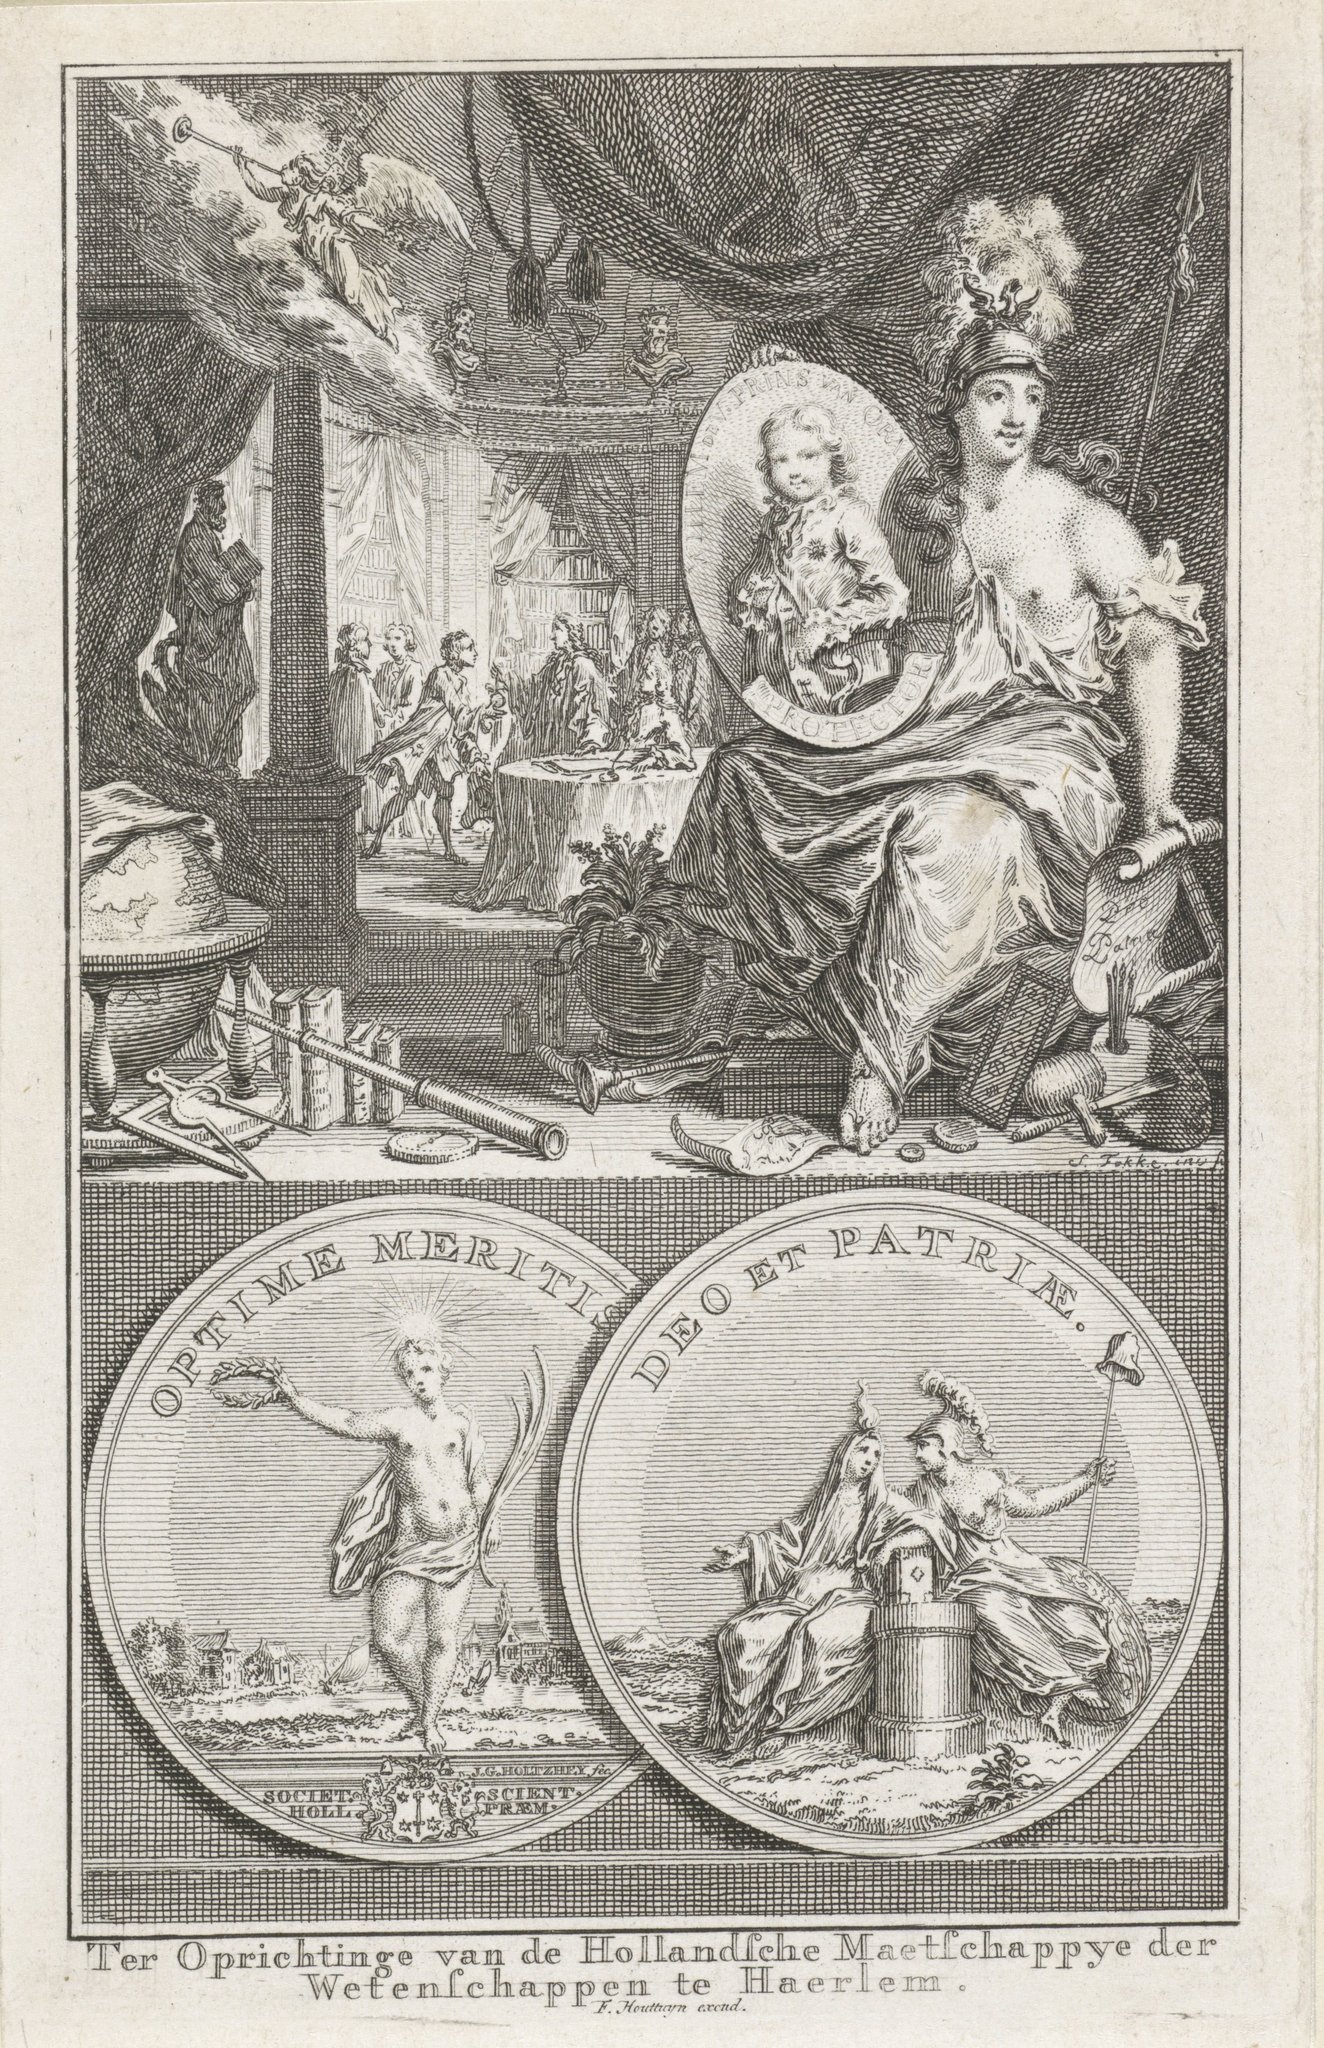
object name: print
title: Ter Oprichtinge van de Hollandsche Maatschappye der Wetenschappen te Haerlem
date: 1752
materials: paper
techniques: engraving, etching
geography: amsterdam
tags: william v (prince of orange), learned society, academy of sciences, (story of) minerva (pallas, athena), haarlem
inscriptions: collector's mark: Lugt 2228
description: Allegorie op de oprichting van de Hollandsche Maatschappij der Wetenschappen te Haarlem op 21 mei 1752. Boven Minerva met een portret van de beschermheer Willem V, op de achtergrond een bijeenkomst van wetenschappers. Onder de zijden van een gedenkpenning met naakte Waarheid met zon op hoofd, houdt in linkerhand een palmtak en in rechterhand een olijfkrans; op achtergrond gezicht op stad Haarlem aan het Spaarne, onderaan het stadswapen van Haarlem. Keerzijde: twee vrouwen zittend bij altaar, voorstellend Godsdienst met vlam op hoofd en leunend op bijbel en Nederland met wapenschild en vrijheidshoed op speer.